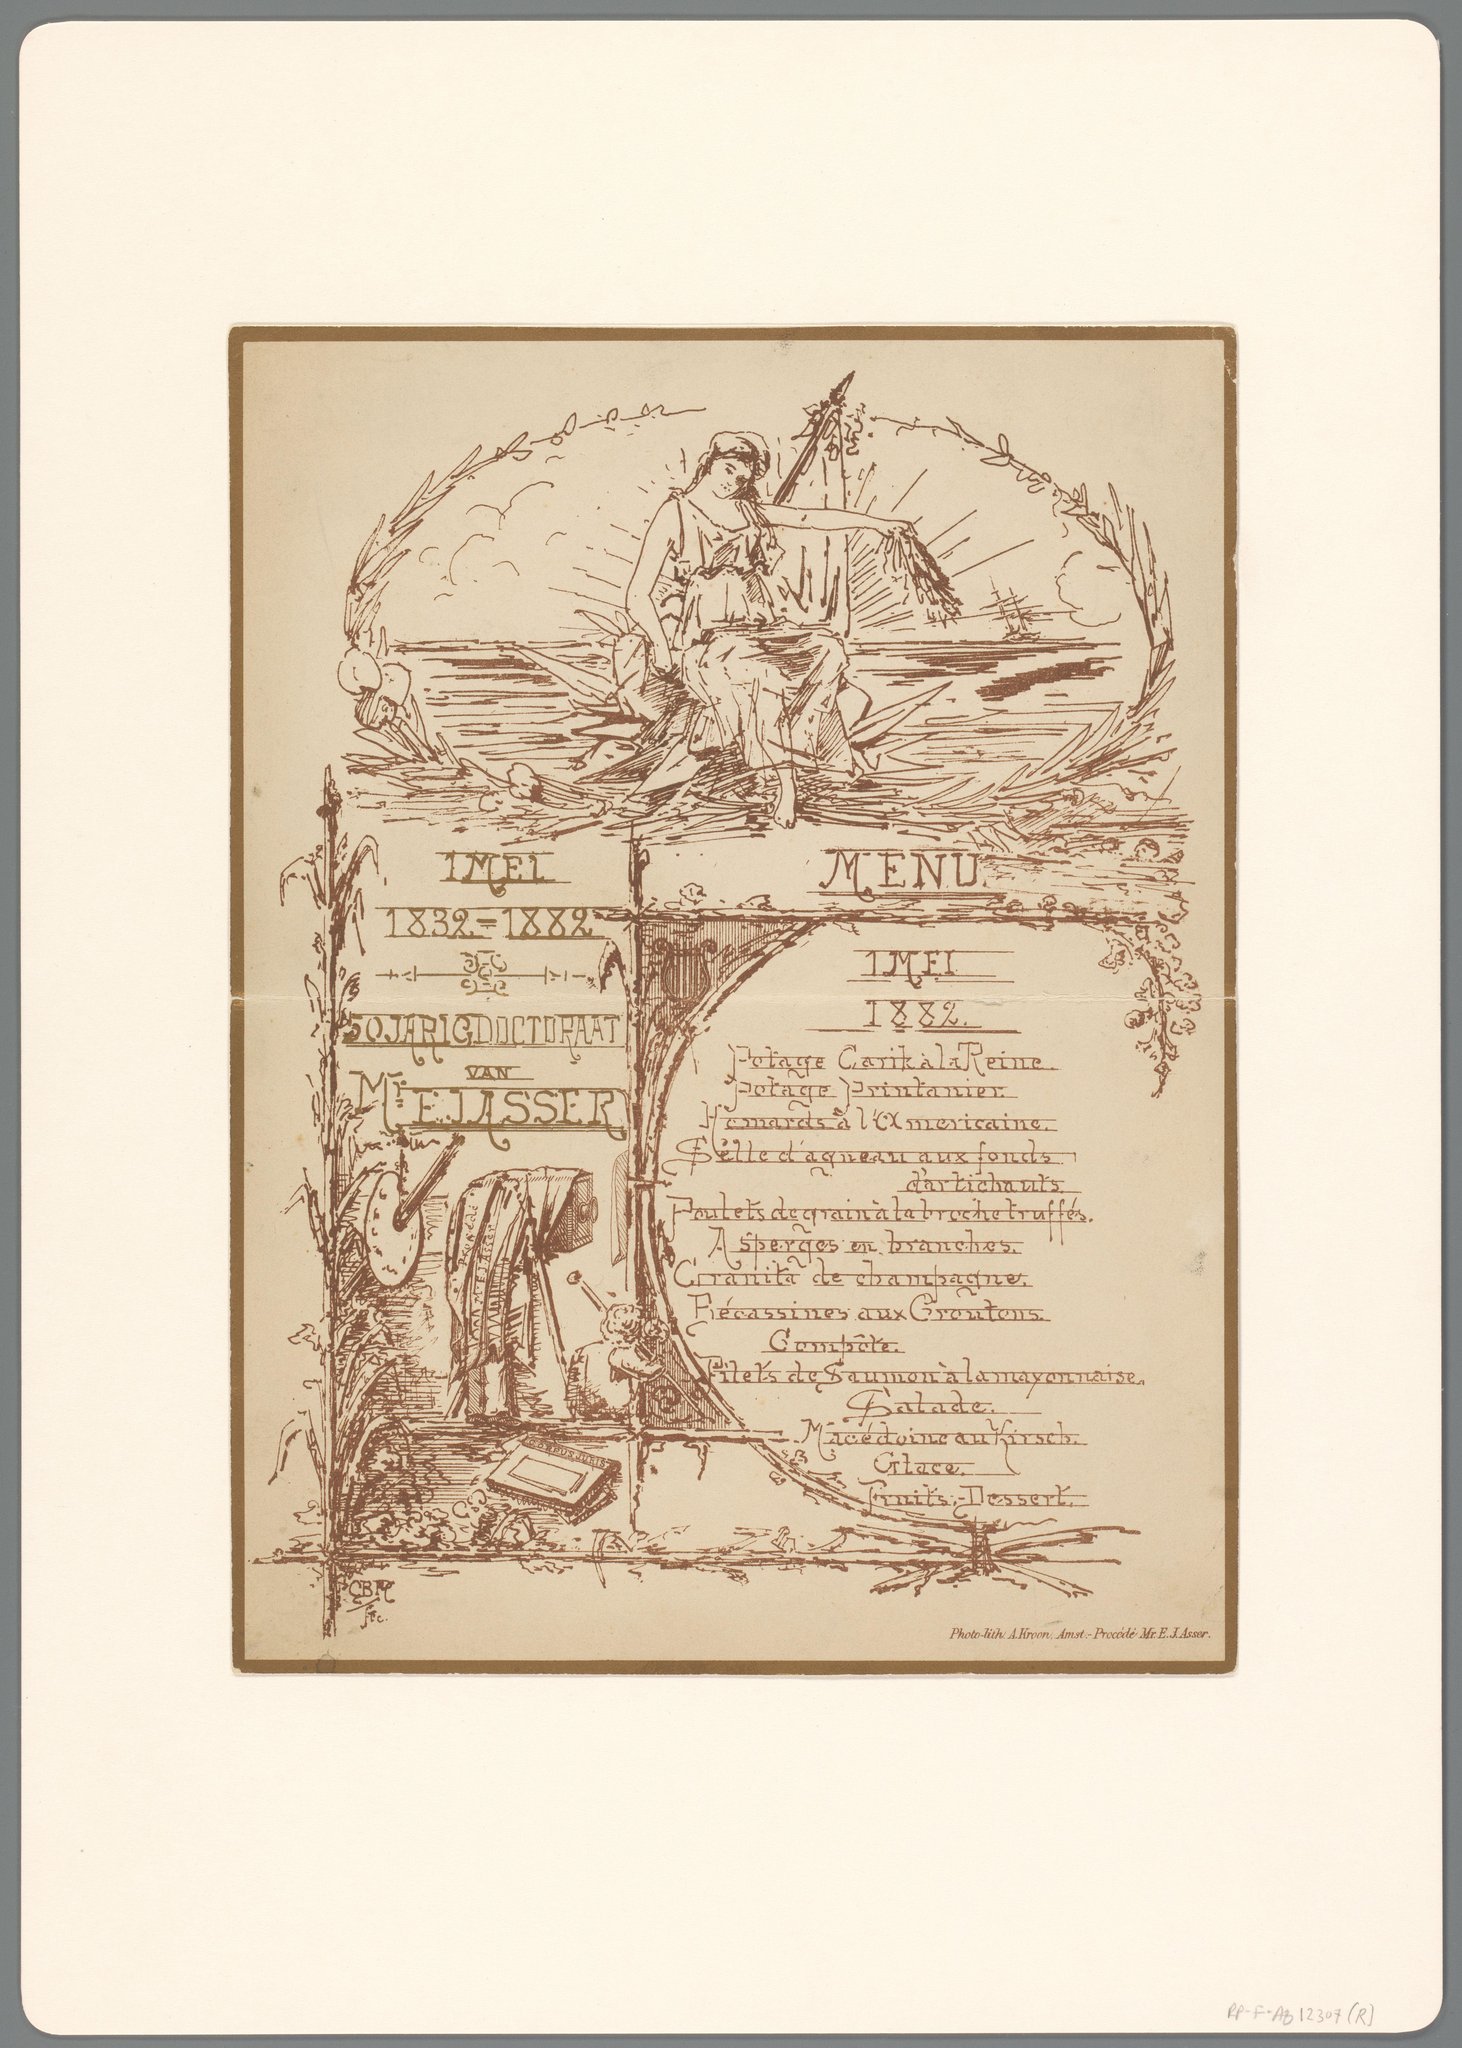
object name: menu, menukaart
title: Menukaart ter gelegenheid van het 50-jarig doctoraat van Mr. E.I. Asser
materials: paper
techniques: photolithograph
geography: amsterdam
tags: netherlands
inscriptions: inscription: ‘Photo-lith A. Kroon, Amst.- Procédé Mr. Asser.’